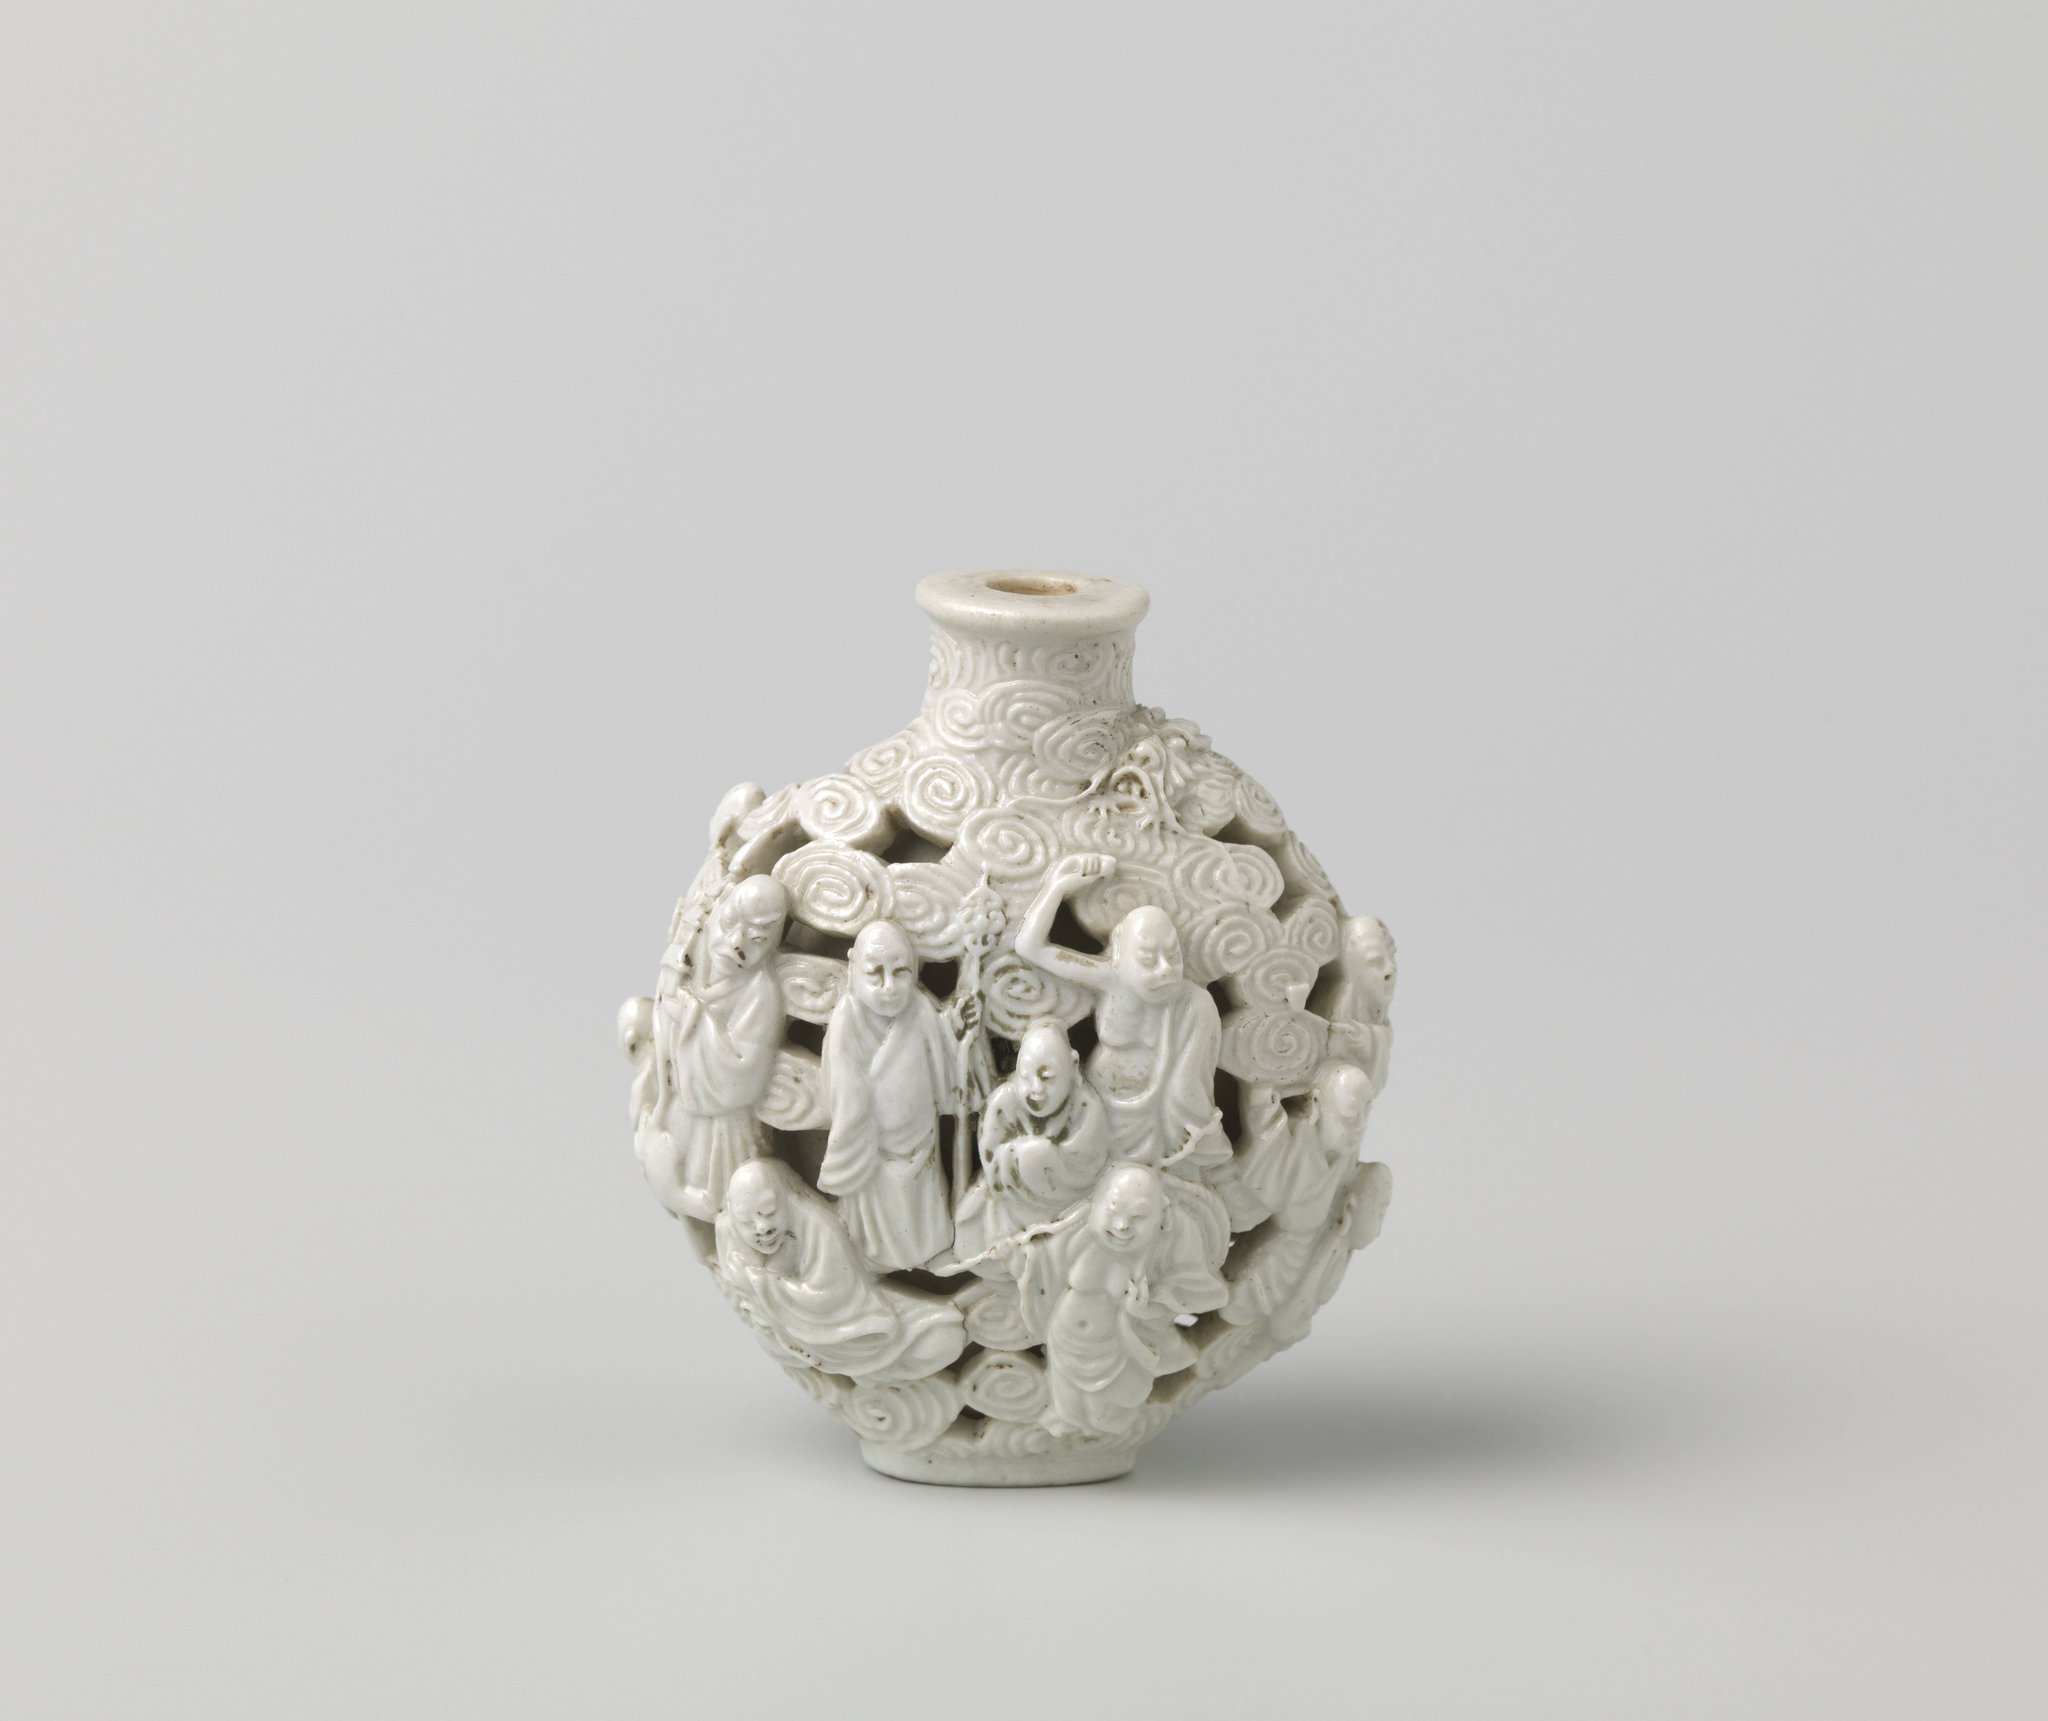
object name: flacon, flakon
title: Snuff bottle with monks on a ground of pierced clouds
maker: Anonymous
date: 1800-1899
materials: glaze, porcelain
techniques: embroidery, forming, turning, vitrification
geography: china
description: Kleine snuiffles van porselein met een dubbele wand, bedekt met een doorschijnend wit glazuur. De buitenwand van de flacon met een groep monninken tegen een grond van opengewerkte wolken. Monochromen, wit porselein.